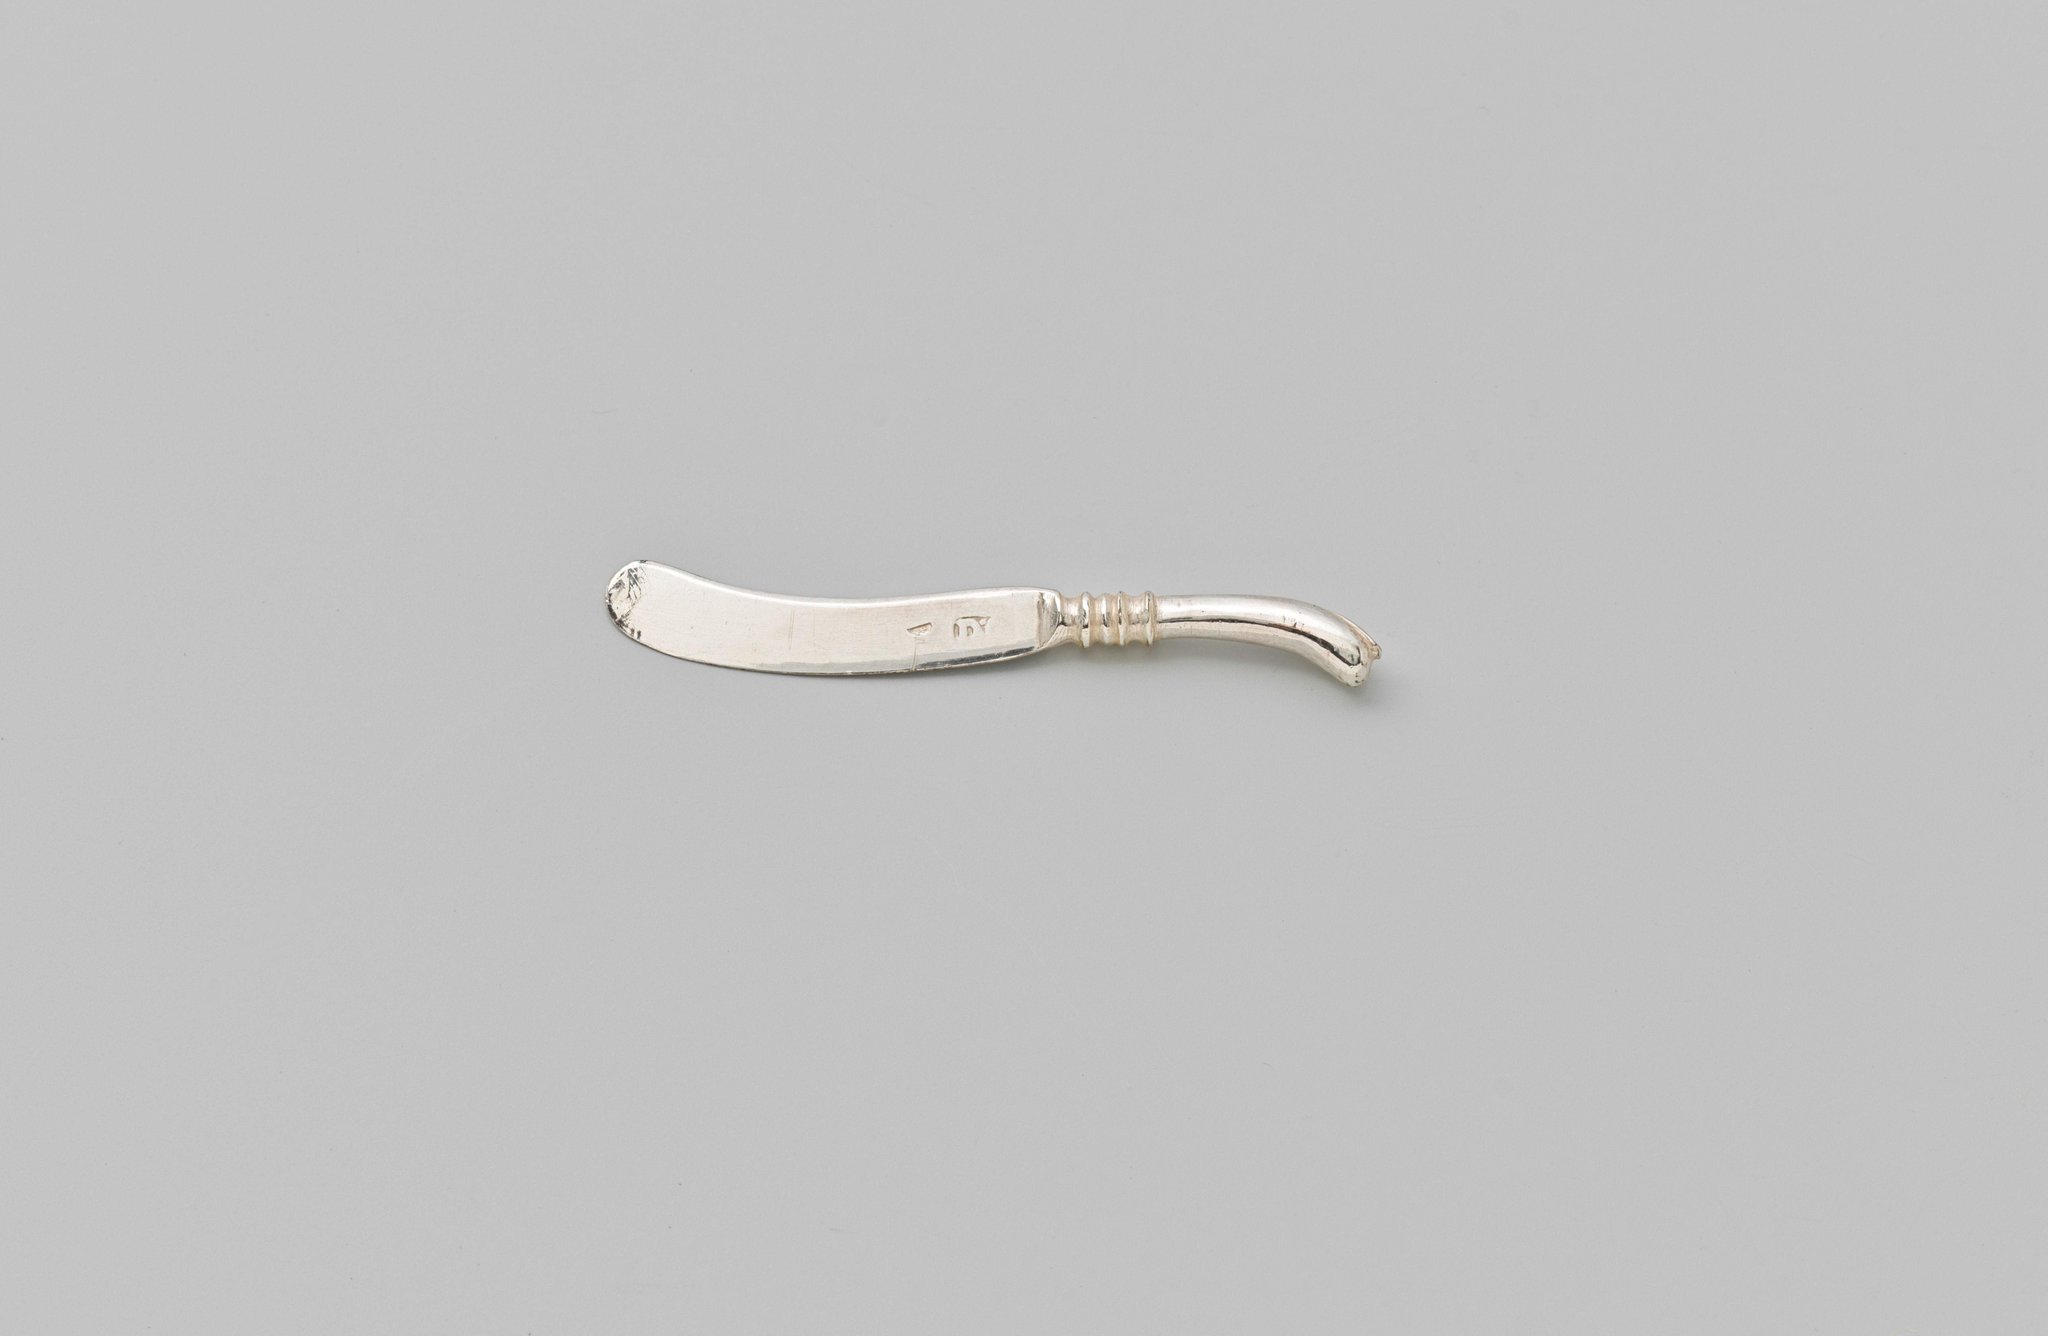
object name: table knife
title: Miniatuur tafelmes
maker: Anonymous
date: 1750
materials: silver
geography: amsterdam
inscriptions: maker's mark: ‘DVS (Citroen 1975, nr. 198)’, town mark: ‘kleine stadskeur Amsterdam’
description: Tafelmes van zilver met pistoolheft, rond gebogen lemmet.